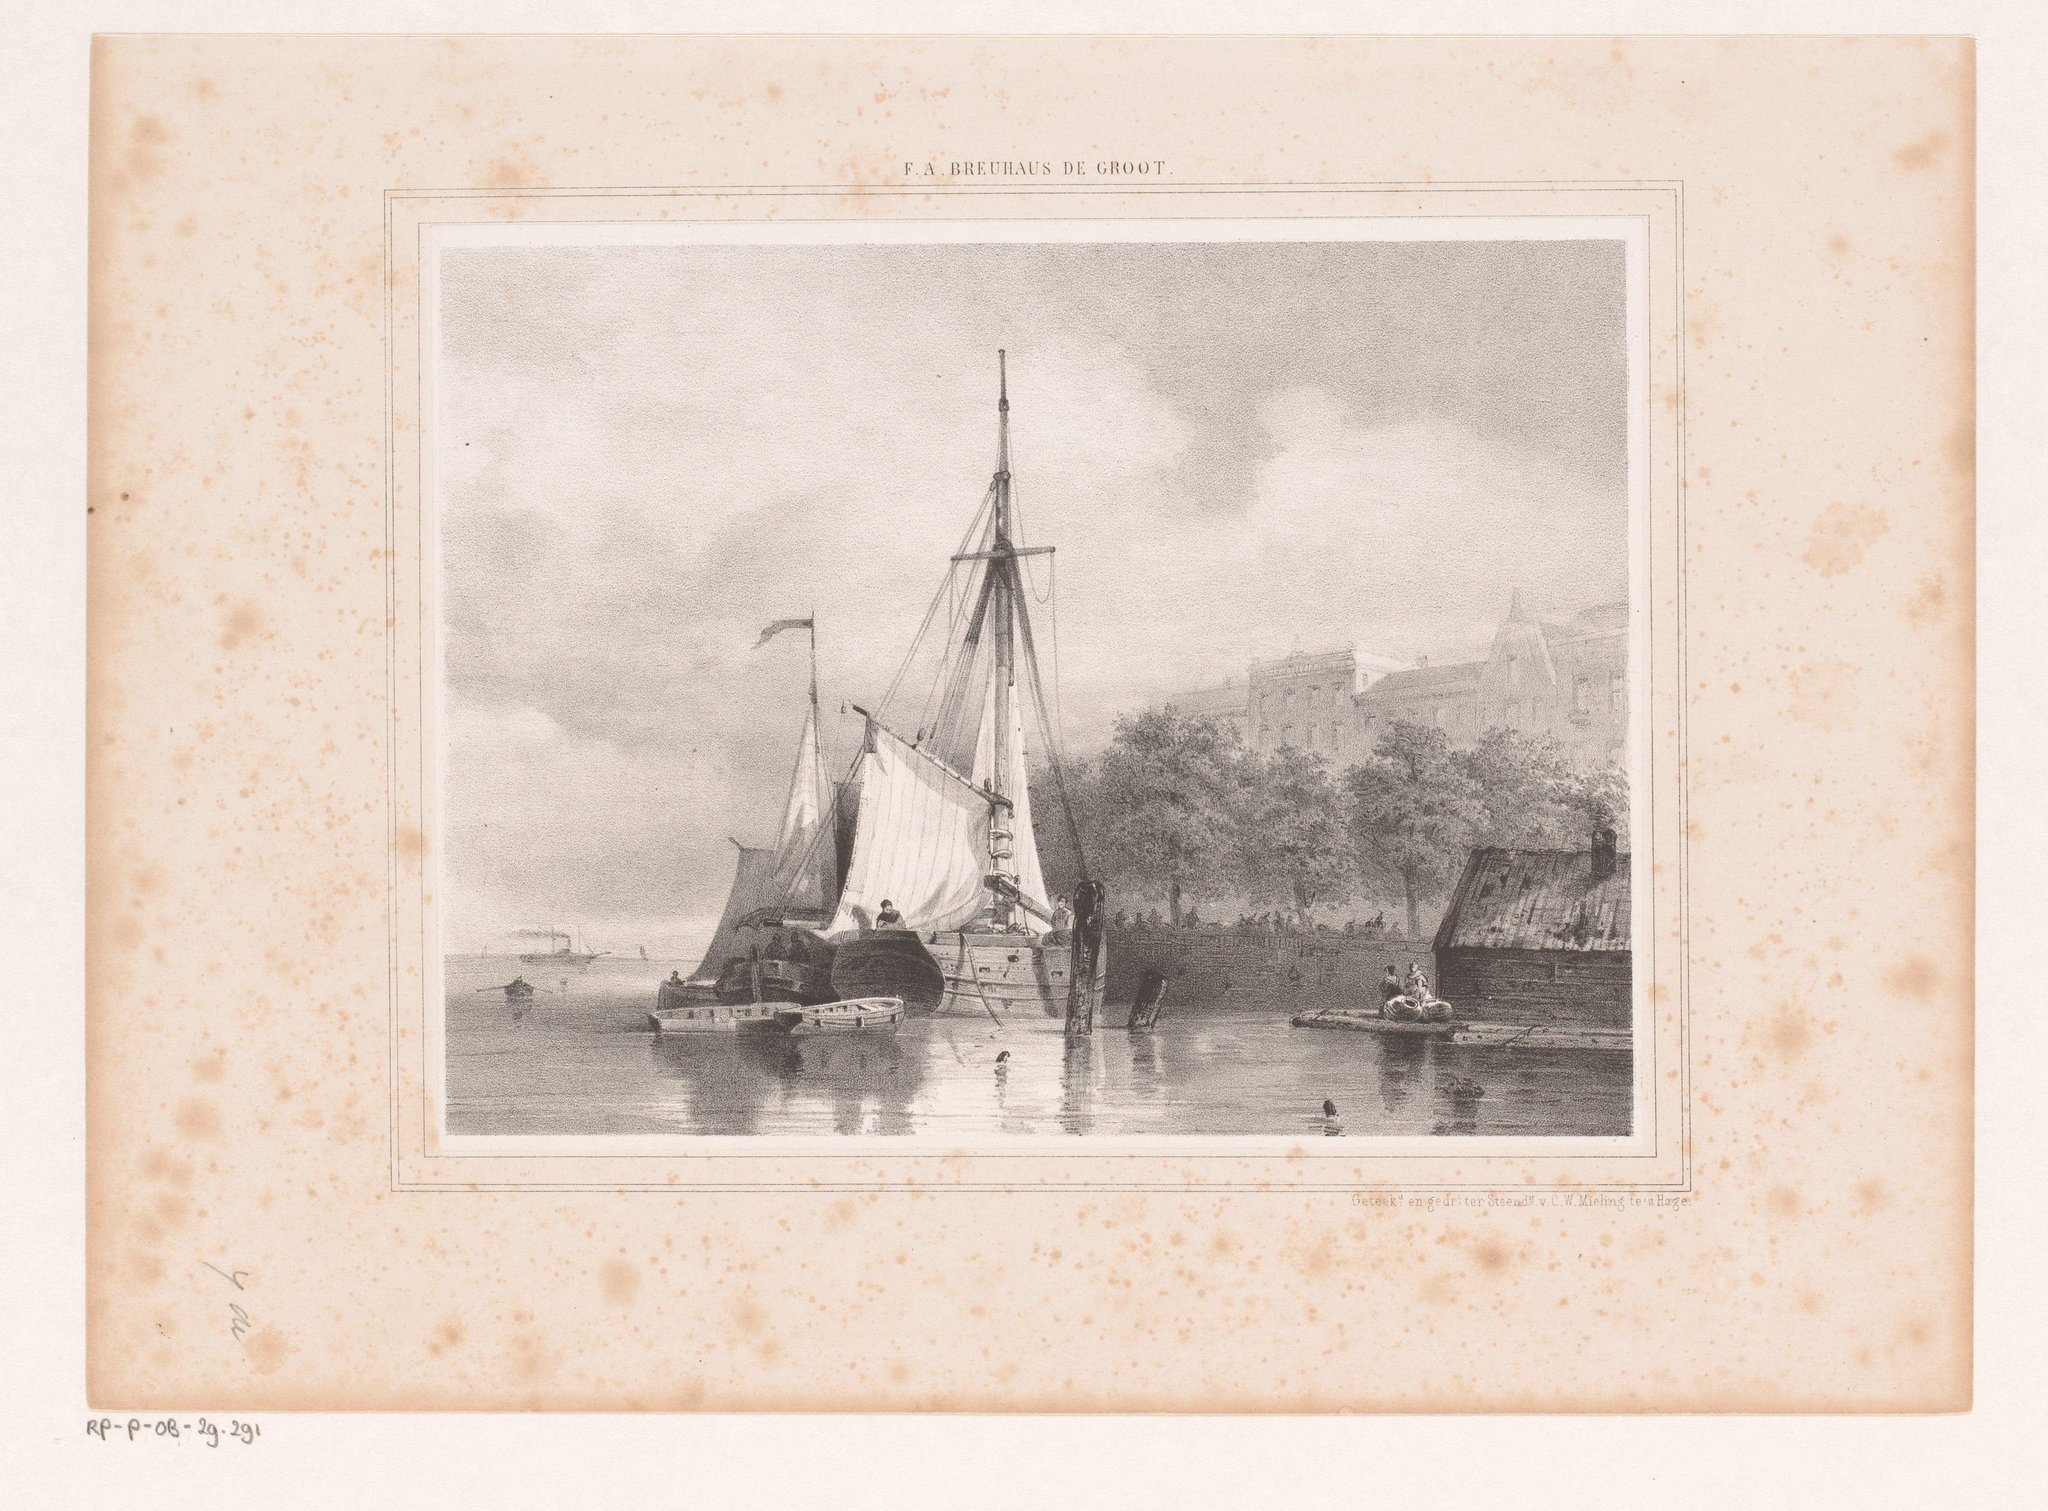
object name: print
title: Schepen aan de kade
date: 1845-1847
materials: paper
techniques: lithograph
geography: the hague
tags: sailing-ship, sailing-boat, pier, quay, wharf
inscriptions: collector's mark: Lugt 2228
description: Op de kade staan mensen onder een rij bomen.